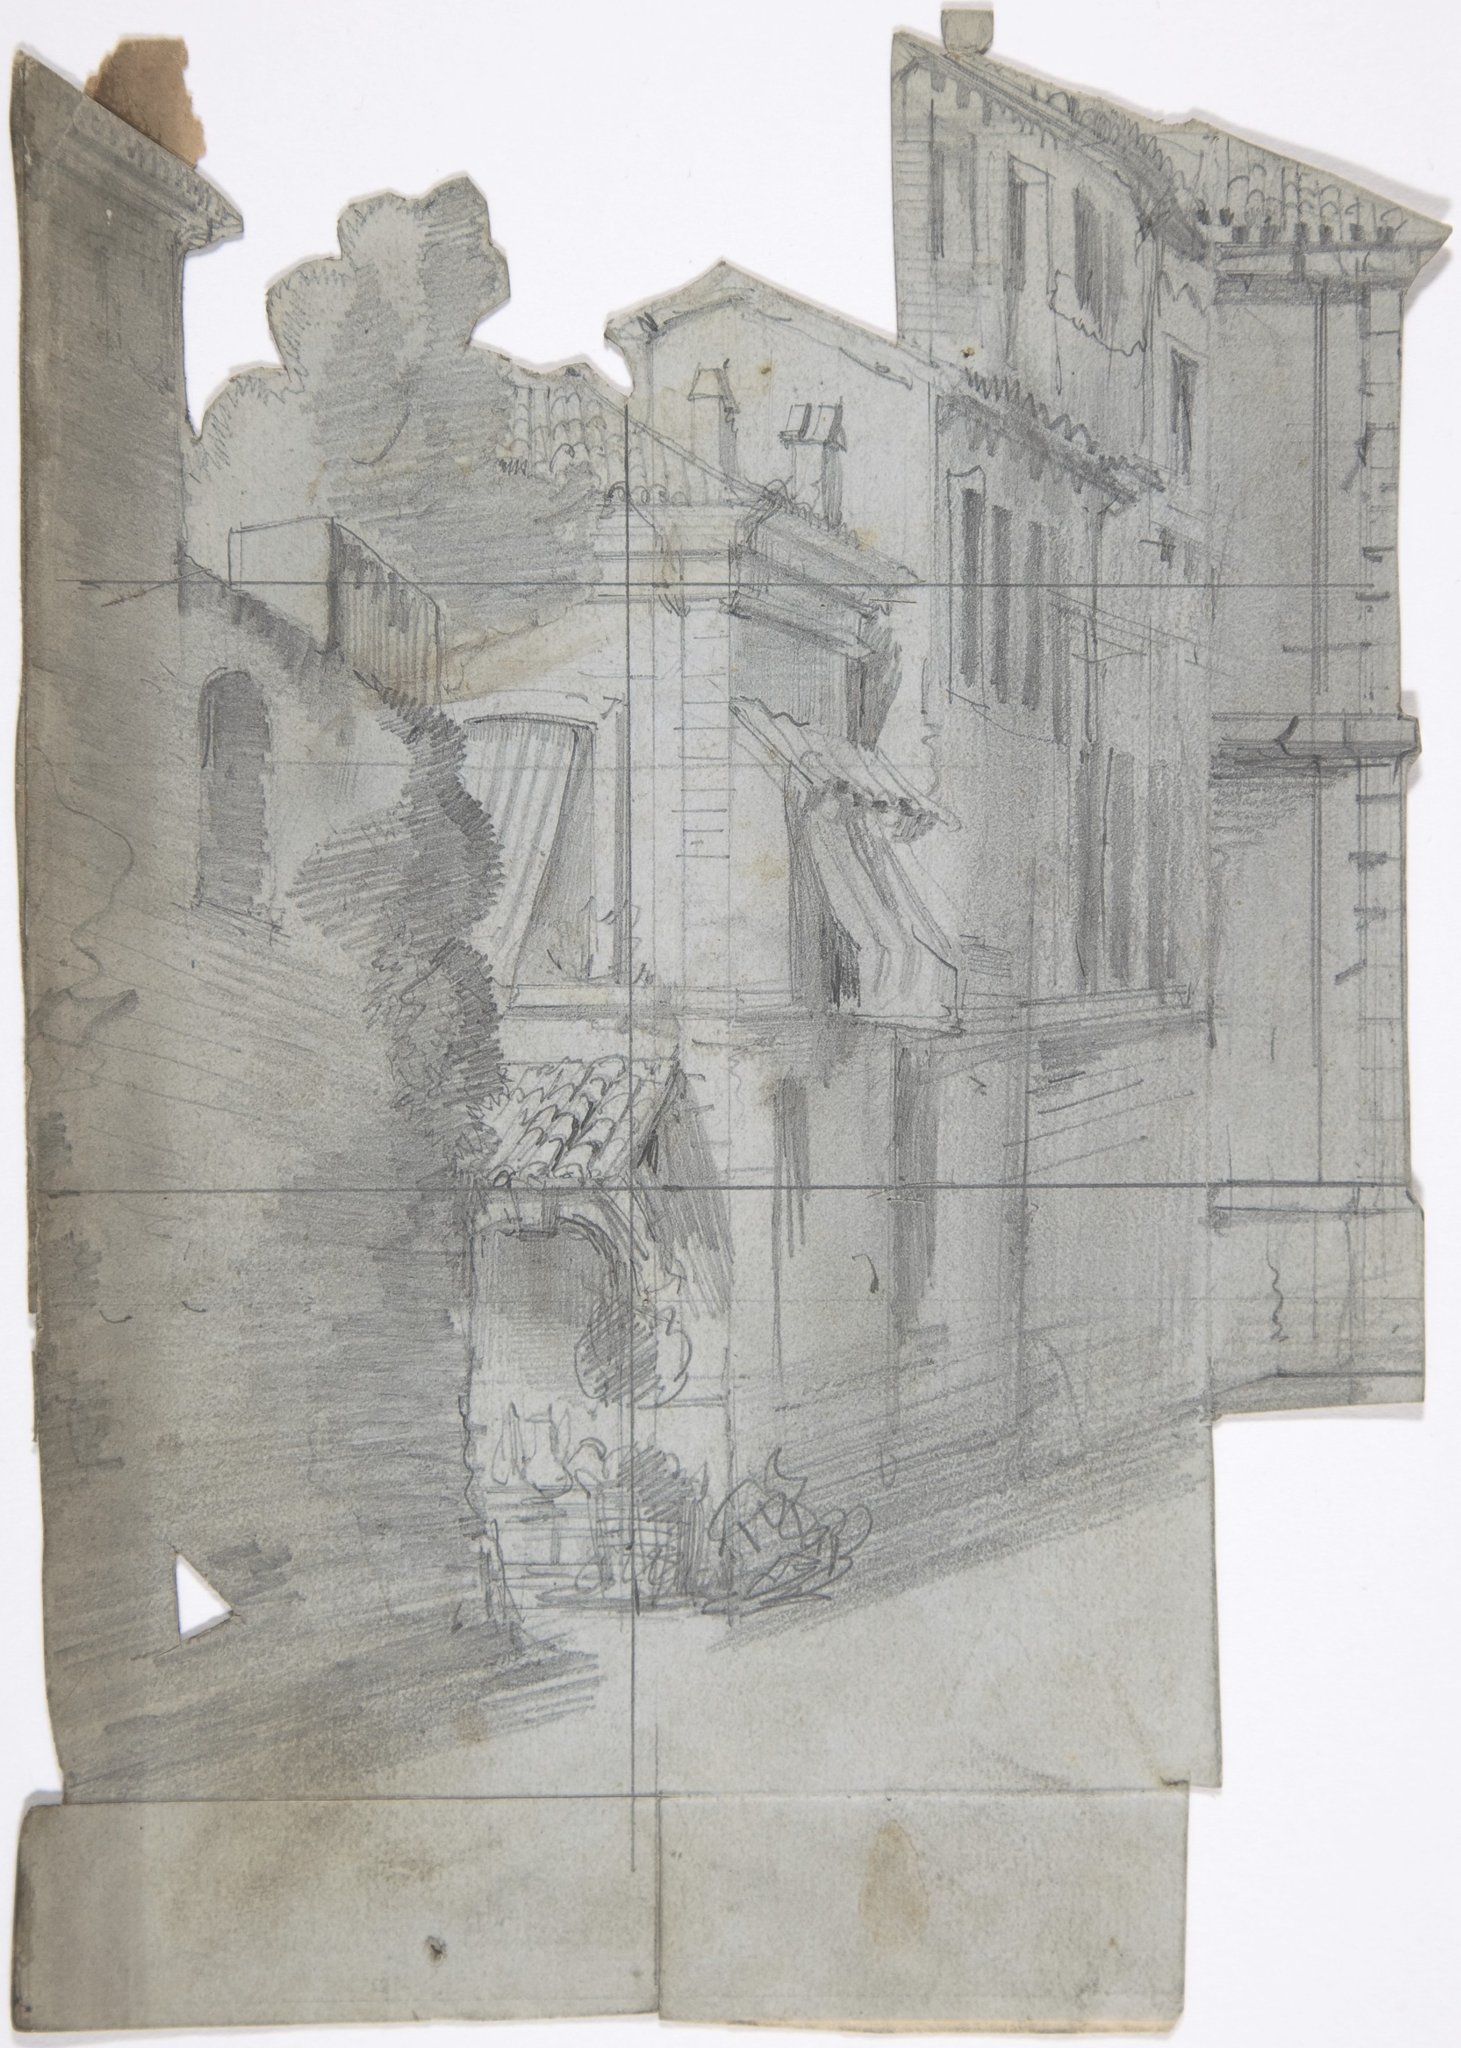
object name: drawing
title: Design for a Stage Set at the Opéra, Paris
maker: eugène cicéri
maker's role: artist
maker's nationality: french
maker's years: 1813-1890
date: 1830-1890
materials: graphite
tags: buildings,stage design